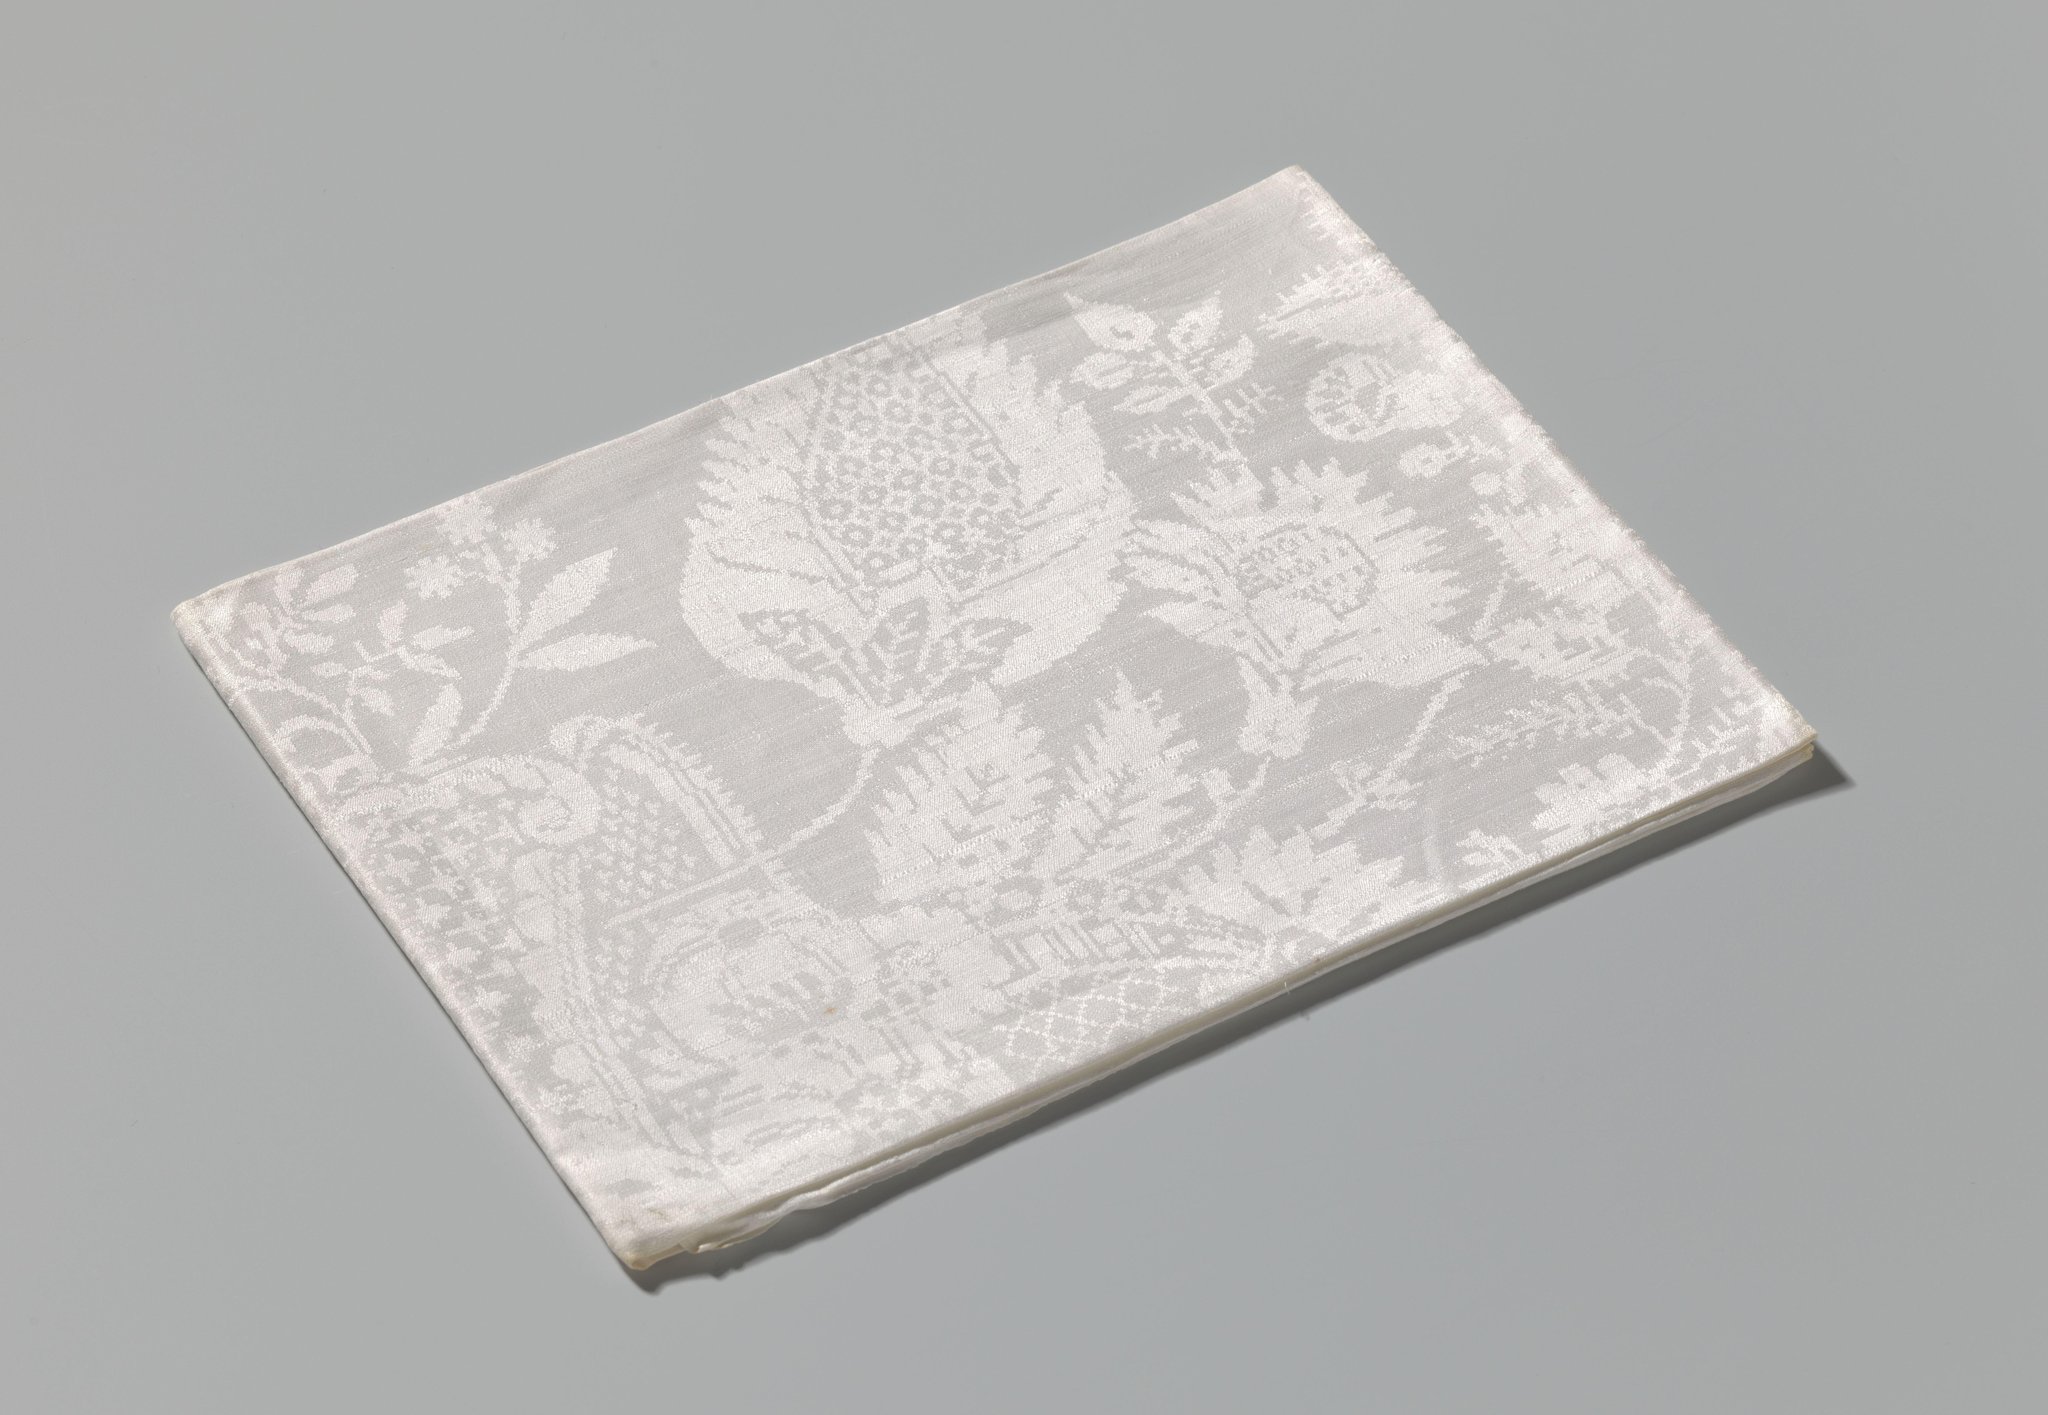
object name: napkin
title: Servet van linnendamast met kantpatroon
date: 1725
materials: linen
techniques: damask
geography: flanders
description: Linnen damasten servet met 'kantpatroon'.